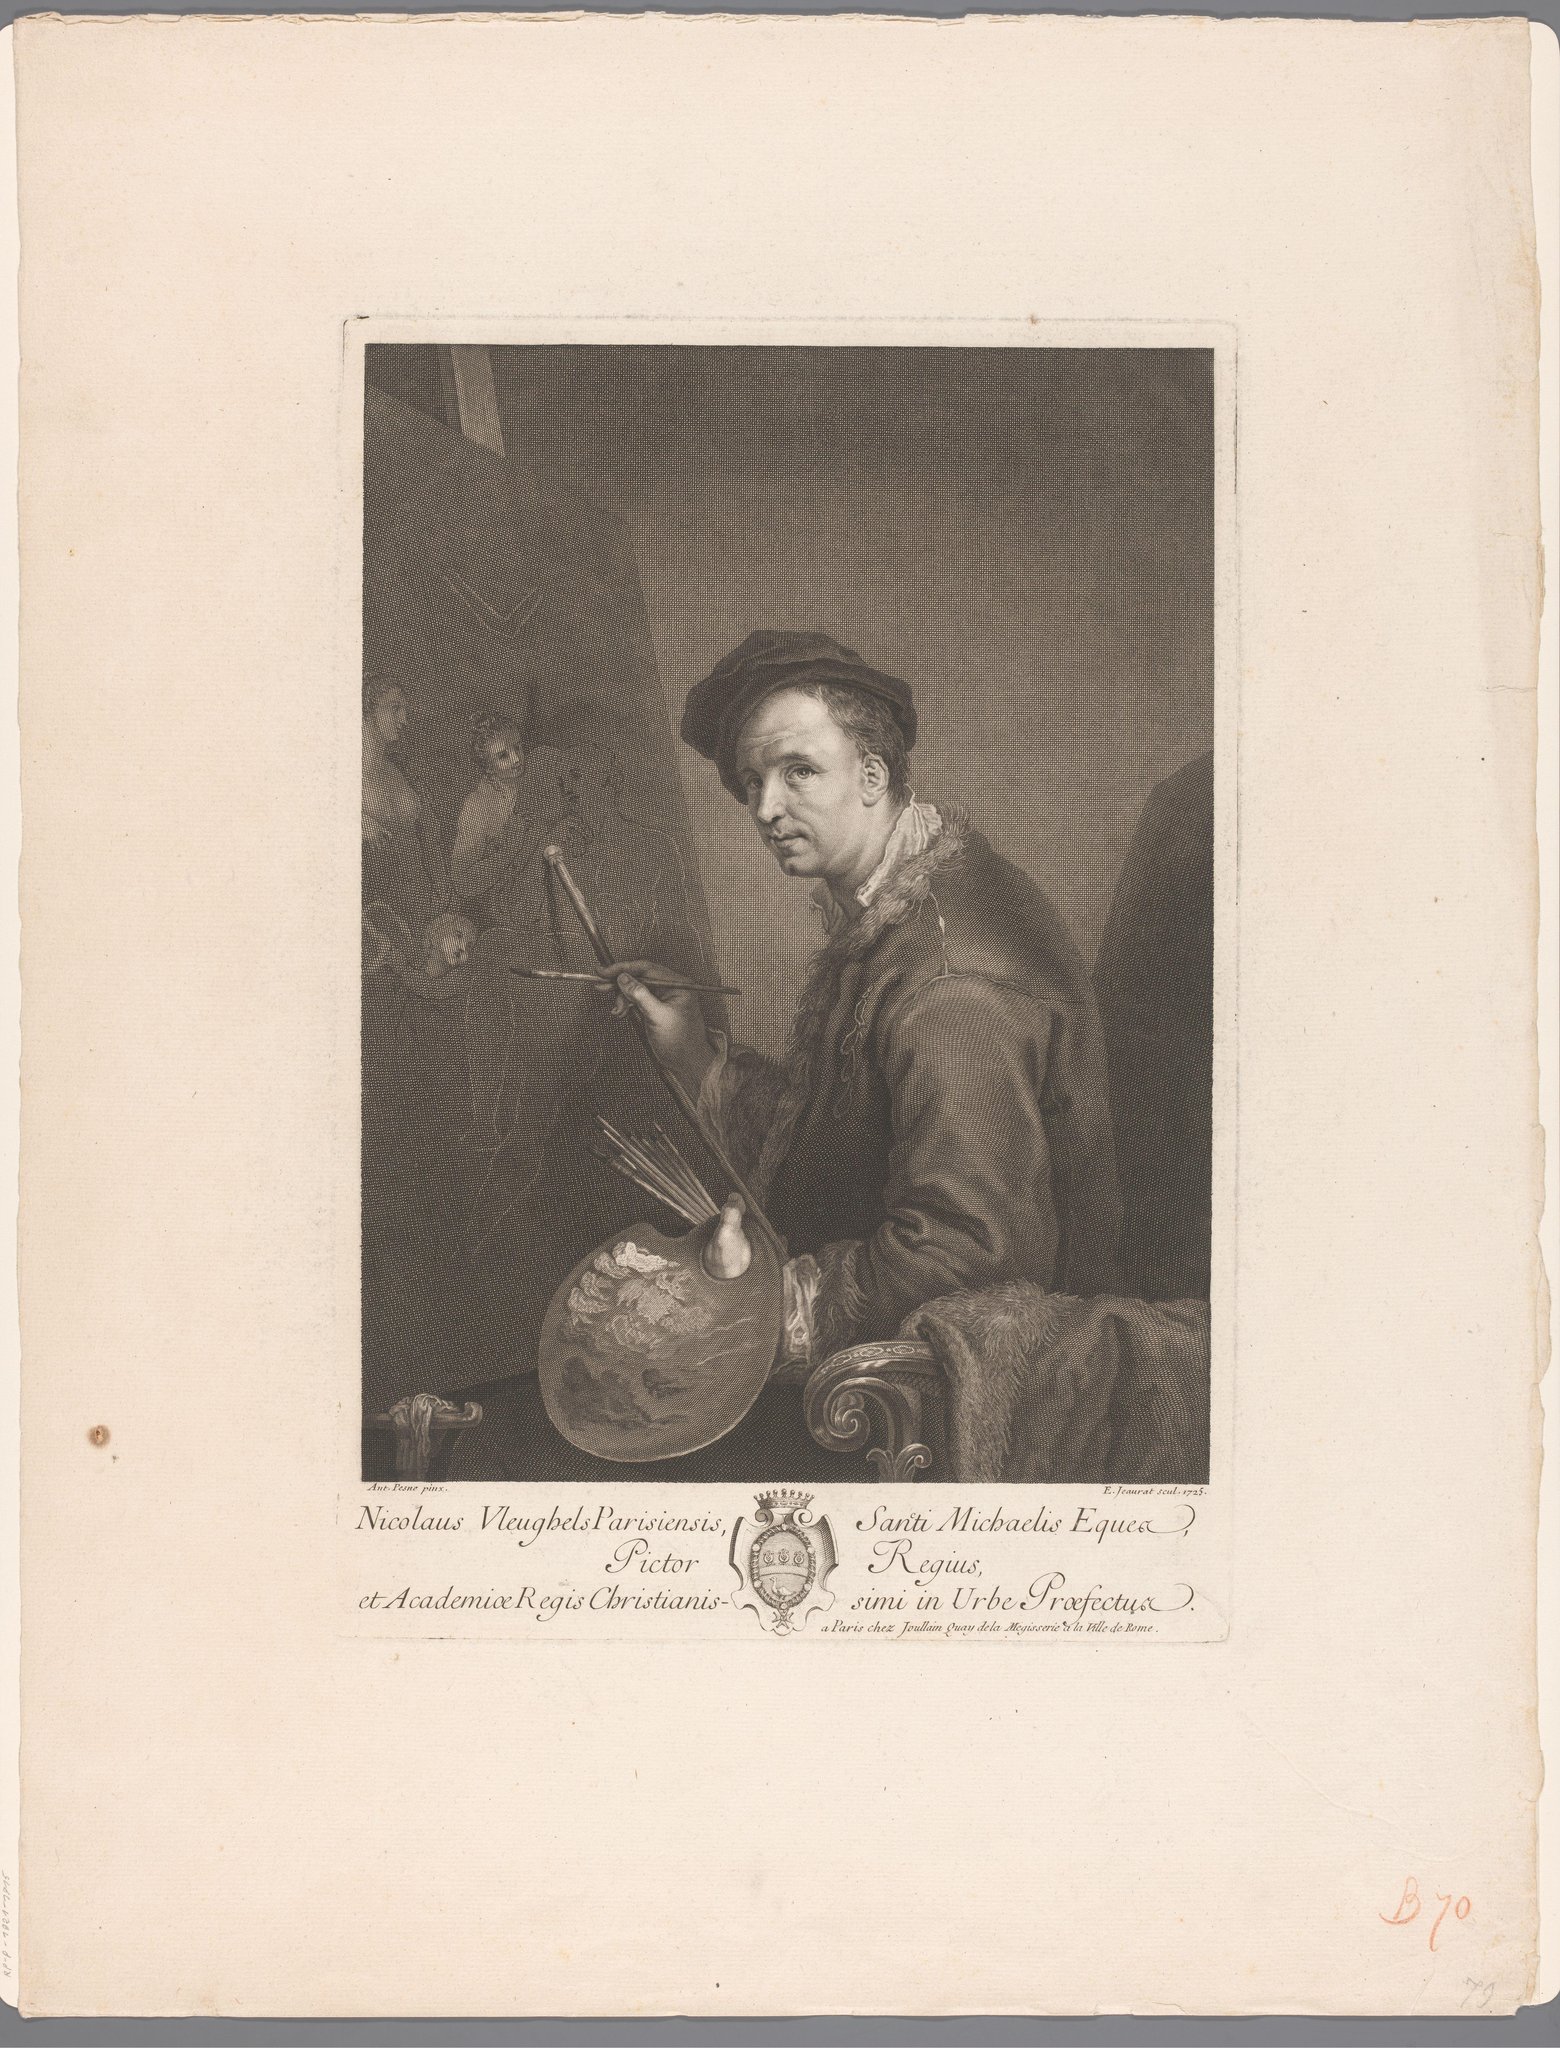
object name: print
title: Portret van Nicolas Vleughels aan zijn schildersezel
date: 1725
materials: paper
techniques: engraving, etching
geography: paris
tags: paris, painter, nicolas vleughels, historical persons, portrait, self-portrait of painter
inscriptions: collector's mark: Lugt 2233